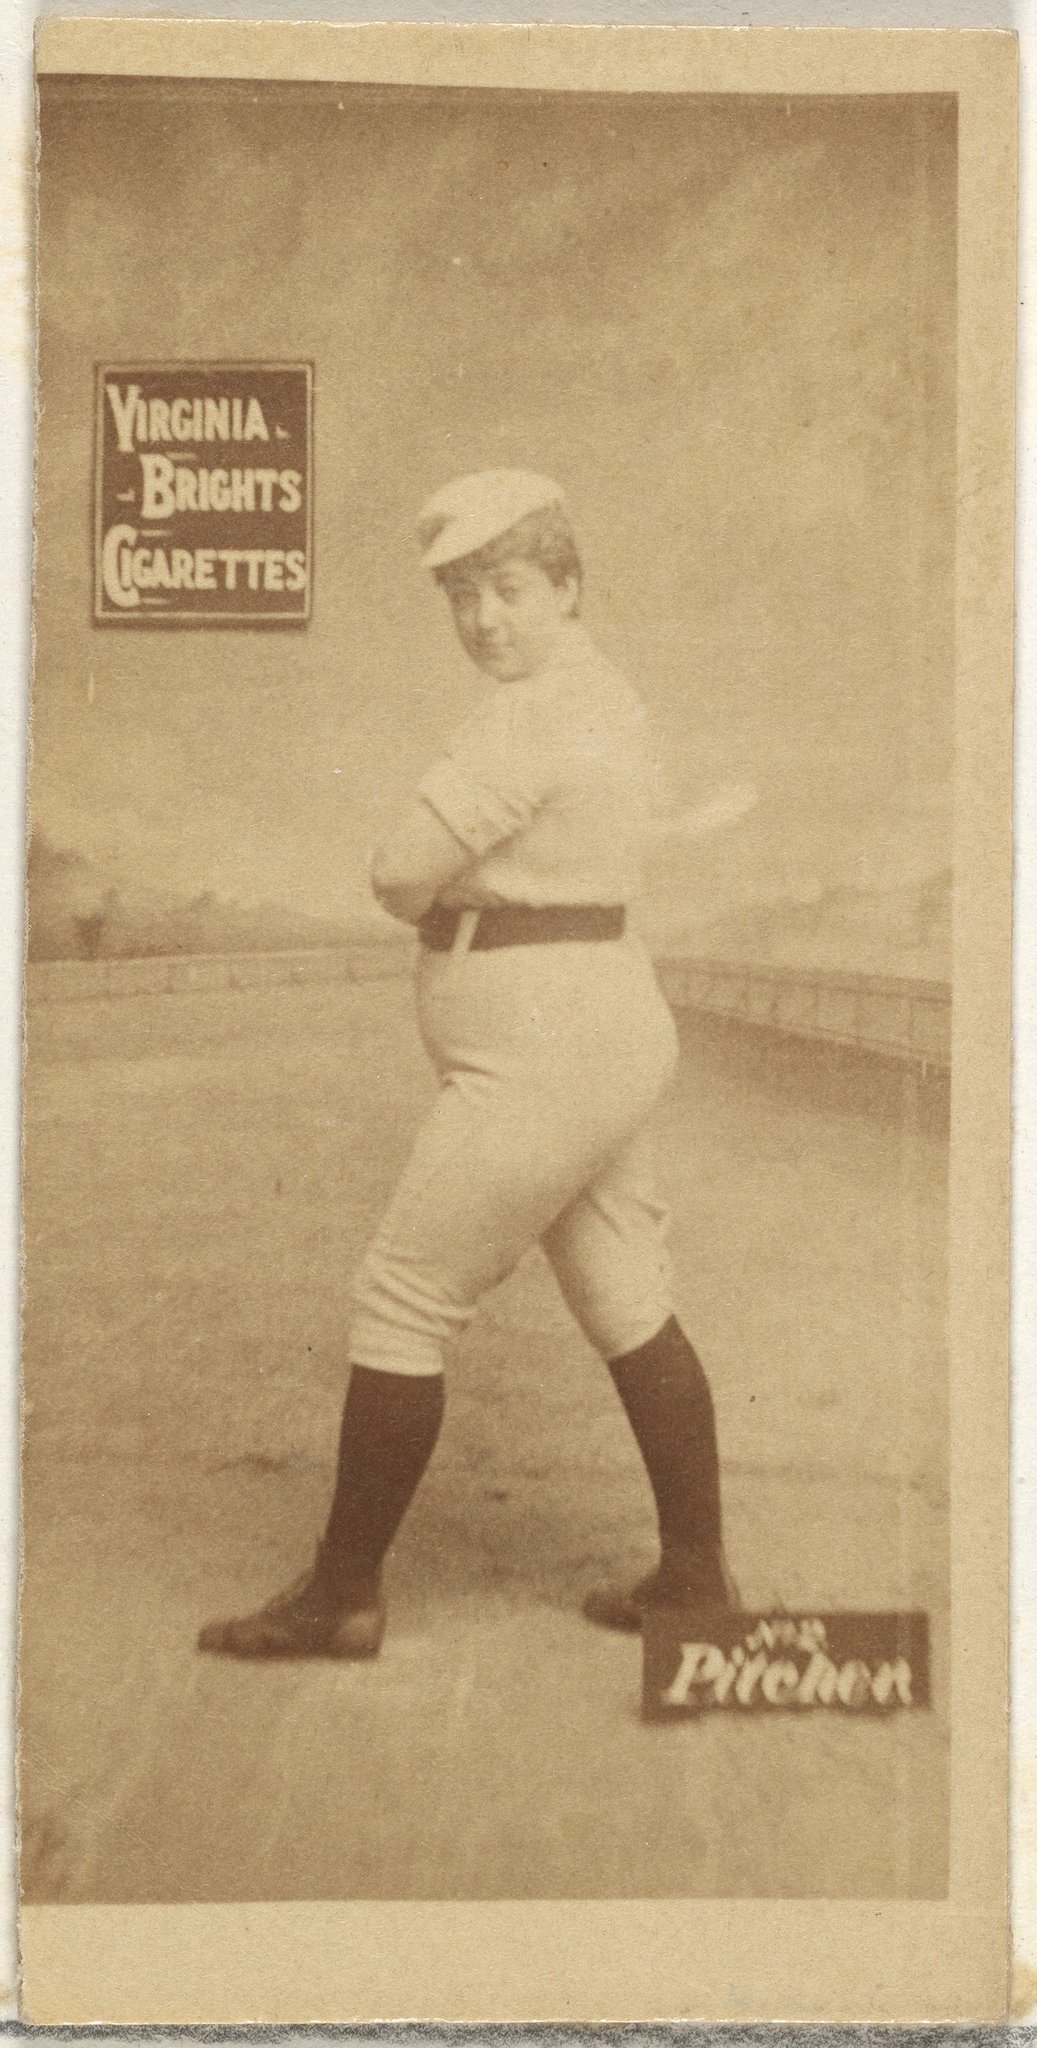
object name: baseball card, photograph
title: Pitcher, from the Girl Baseball Players series (N48, Type 2) for Virginia Brights Cigarettes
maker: allen & ginter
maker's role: publisher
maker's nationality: american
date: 1886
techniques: albumen silver print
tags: portraits,women,baseball,athletes